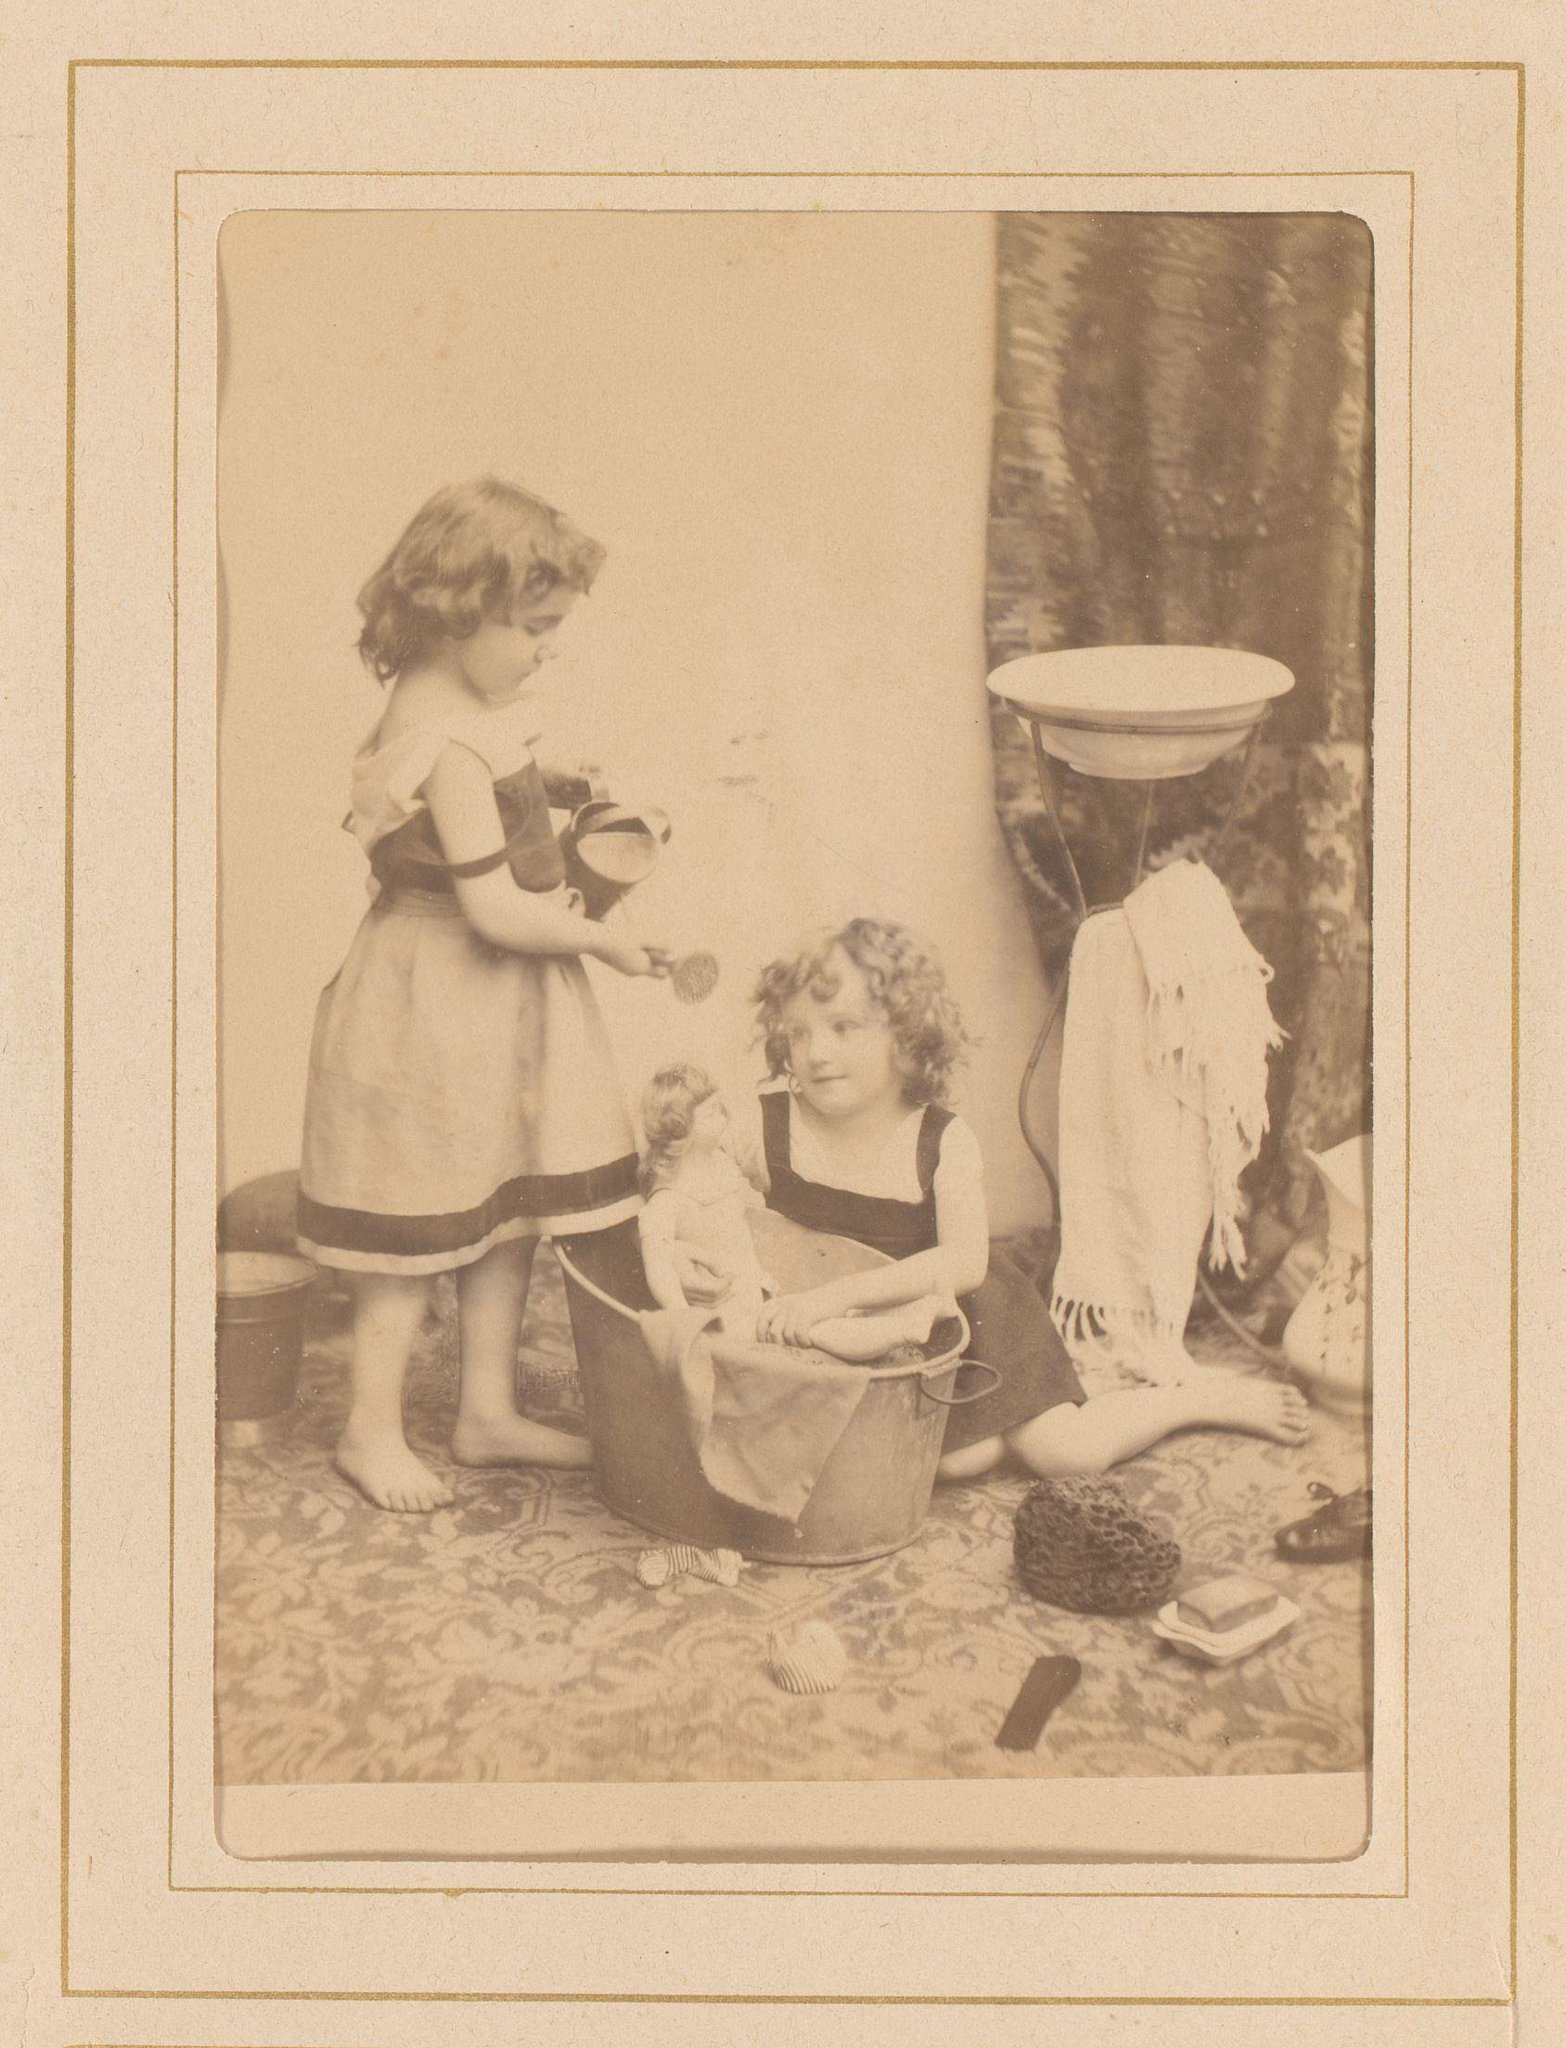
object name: cabinet photograph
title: Twee spelende meisjes met pop, teil en gieter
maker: e. linde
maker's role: publisher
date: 1885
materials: cardboard, photographic support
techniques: albumen print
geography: berlin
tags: girl (child between toddler and youth), (playing with) dolls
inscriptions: inscription: ‘No. 174. Das Kinder Bad. - Bain des Enfants./ Berlin W. 1885/ E. Linde Kunstverlag’